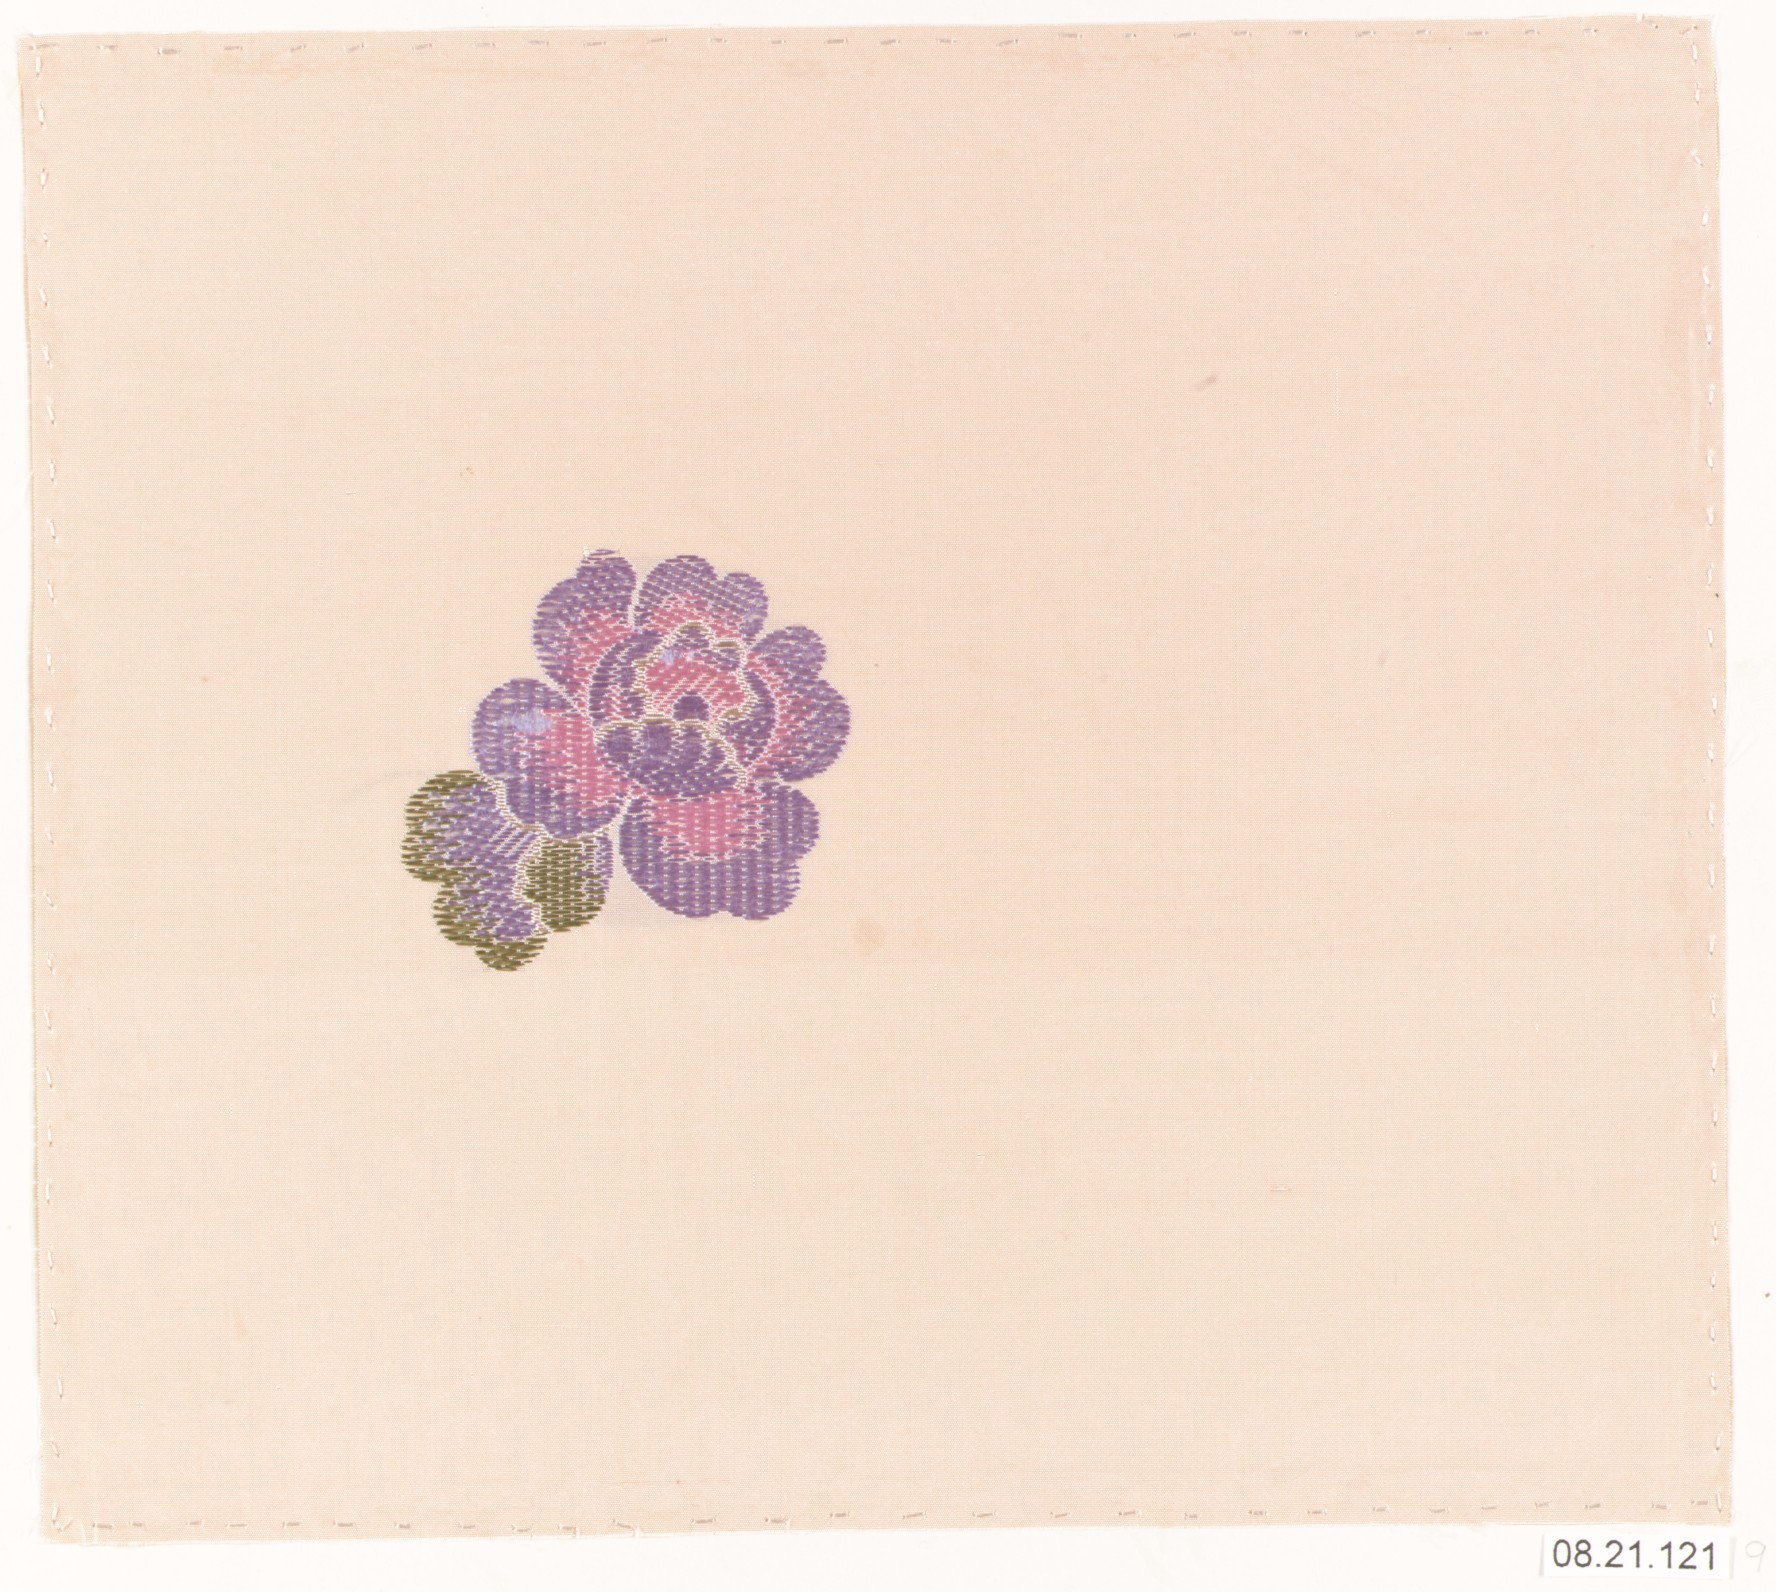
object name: textile sample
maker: Anonymous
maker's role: designer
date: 1900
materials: silk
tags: flowers